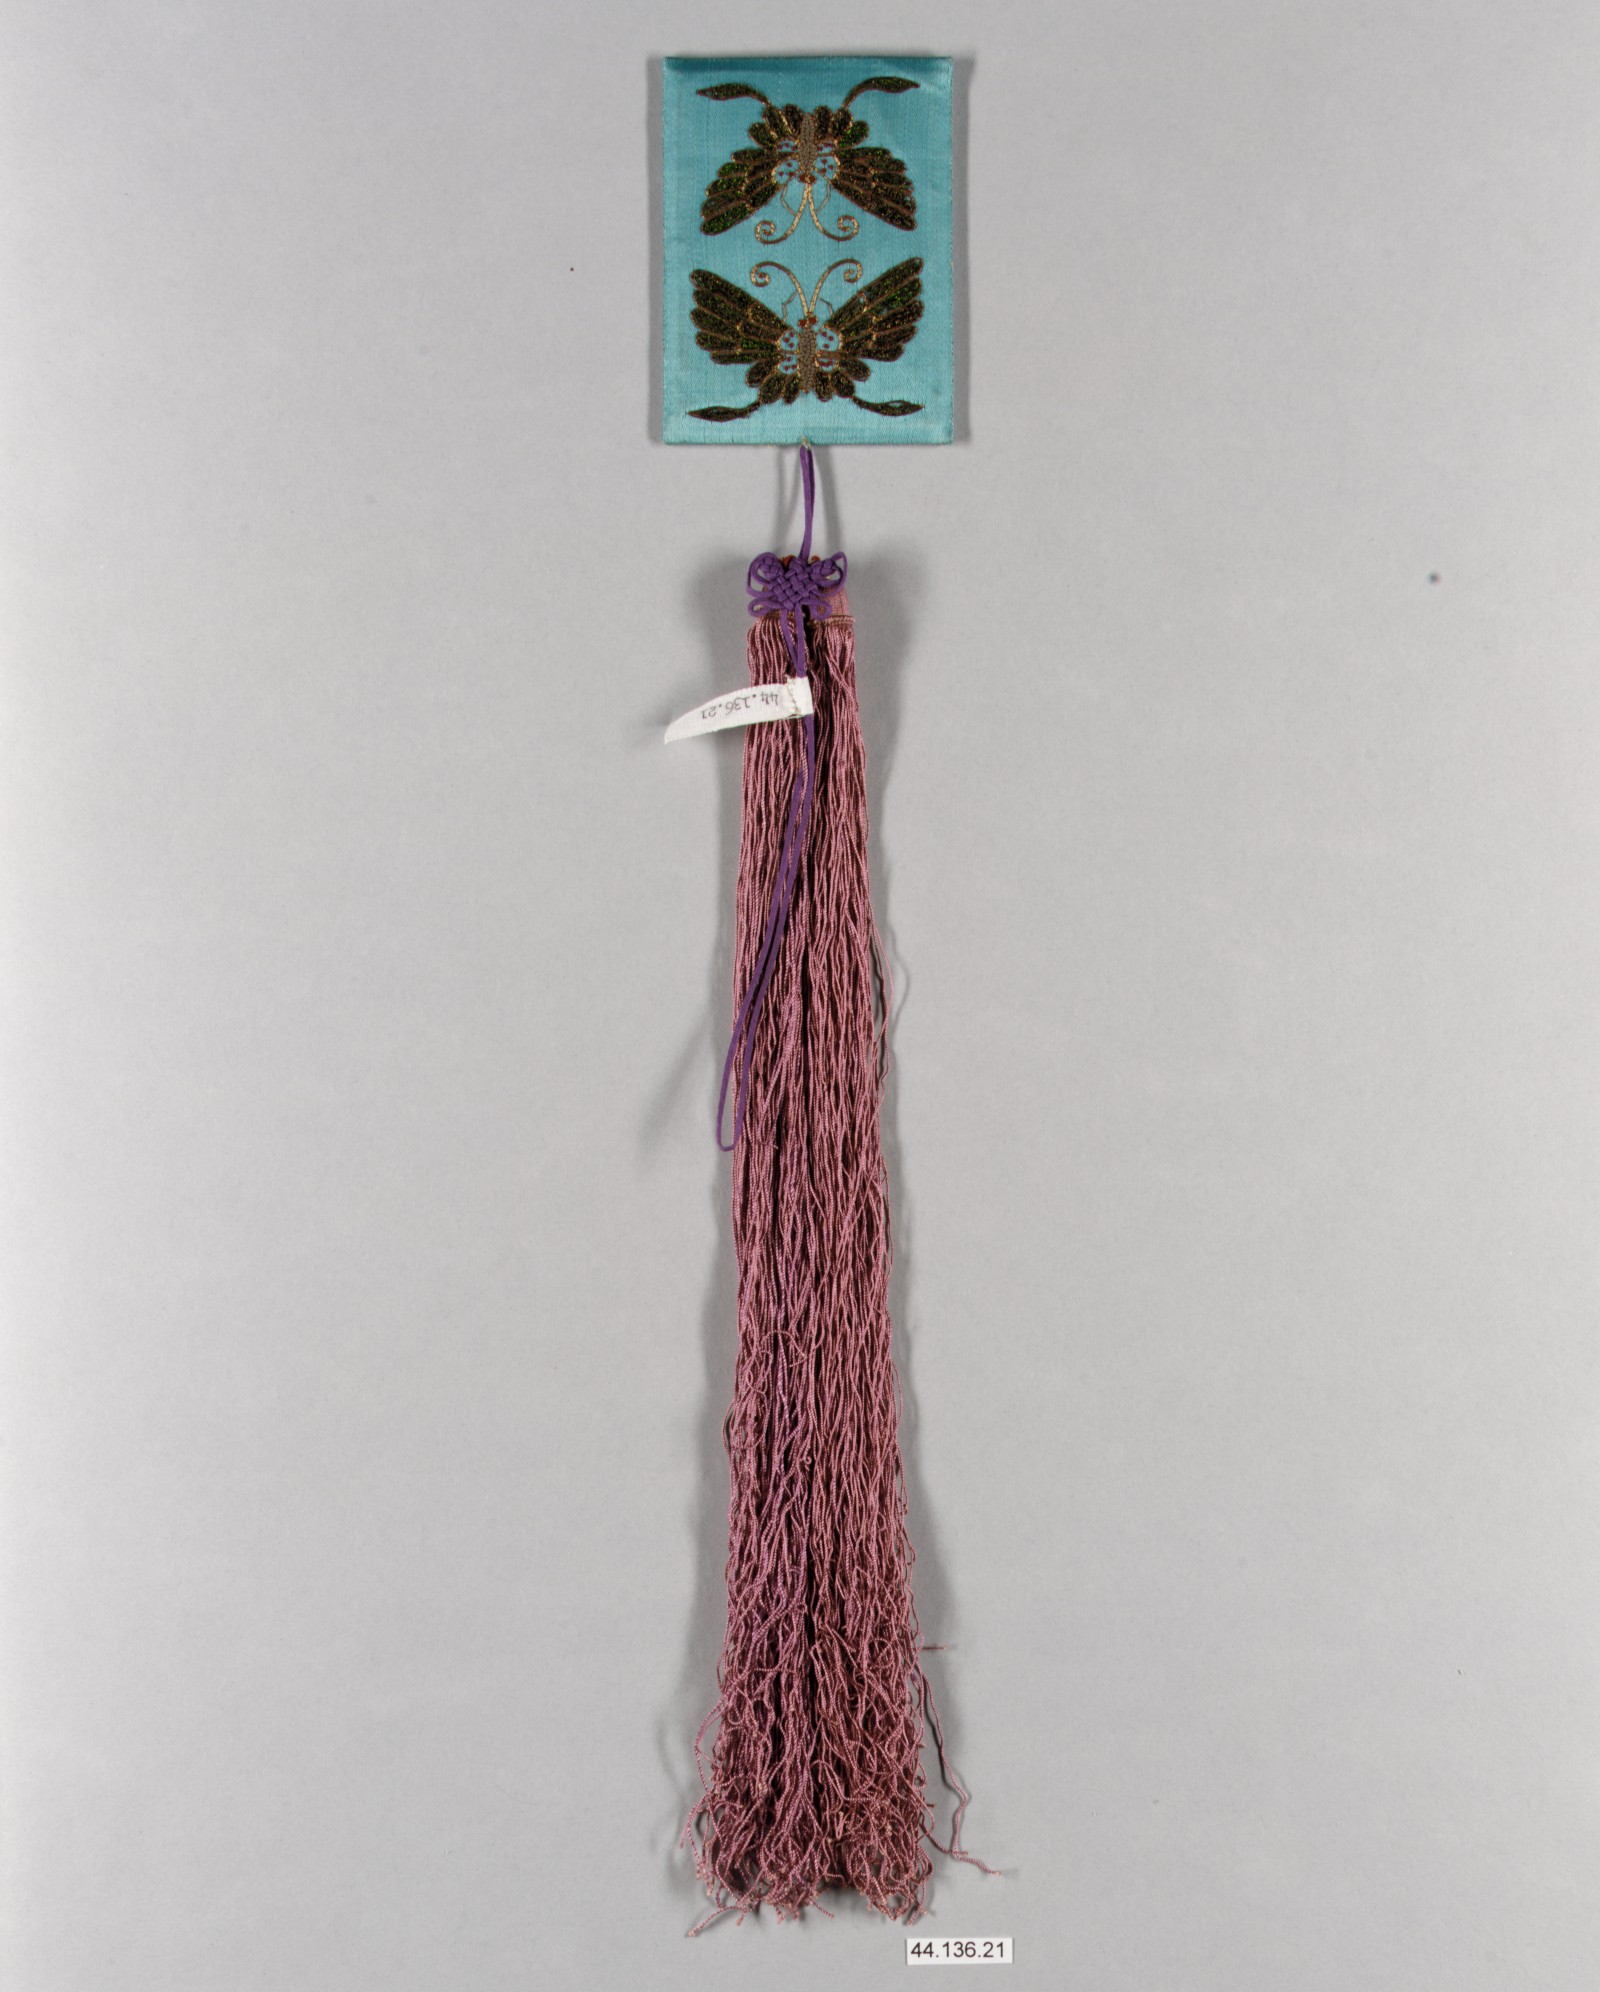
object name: mirror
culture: chinese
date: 1801-1900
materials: feather, glass, metal thread, silk